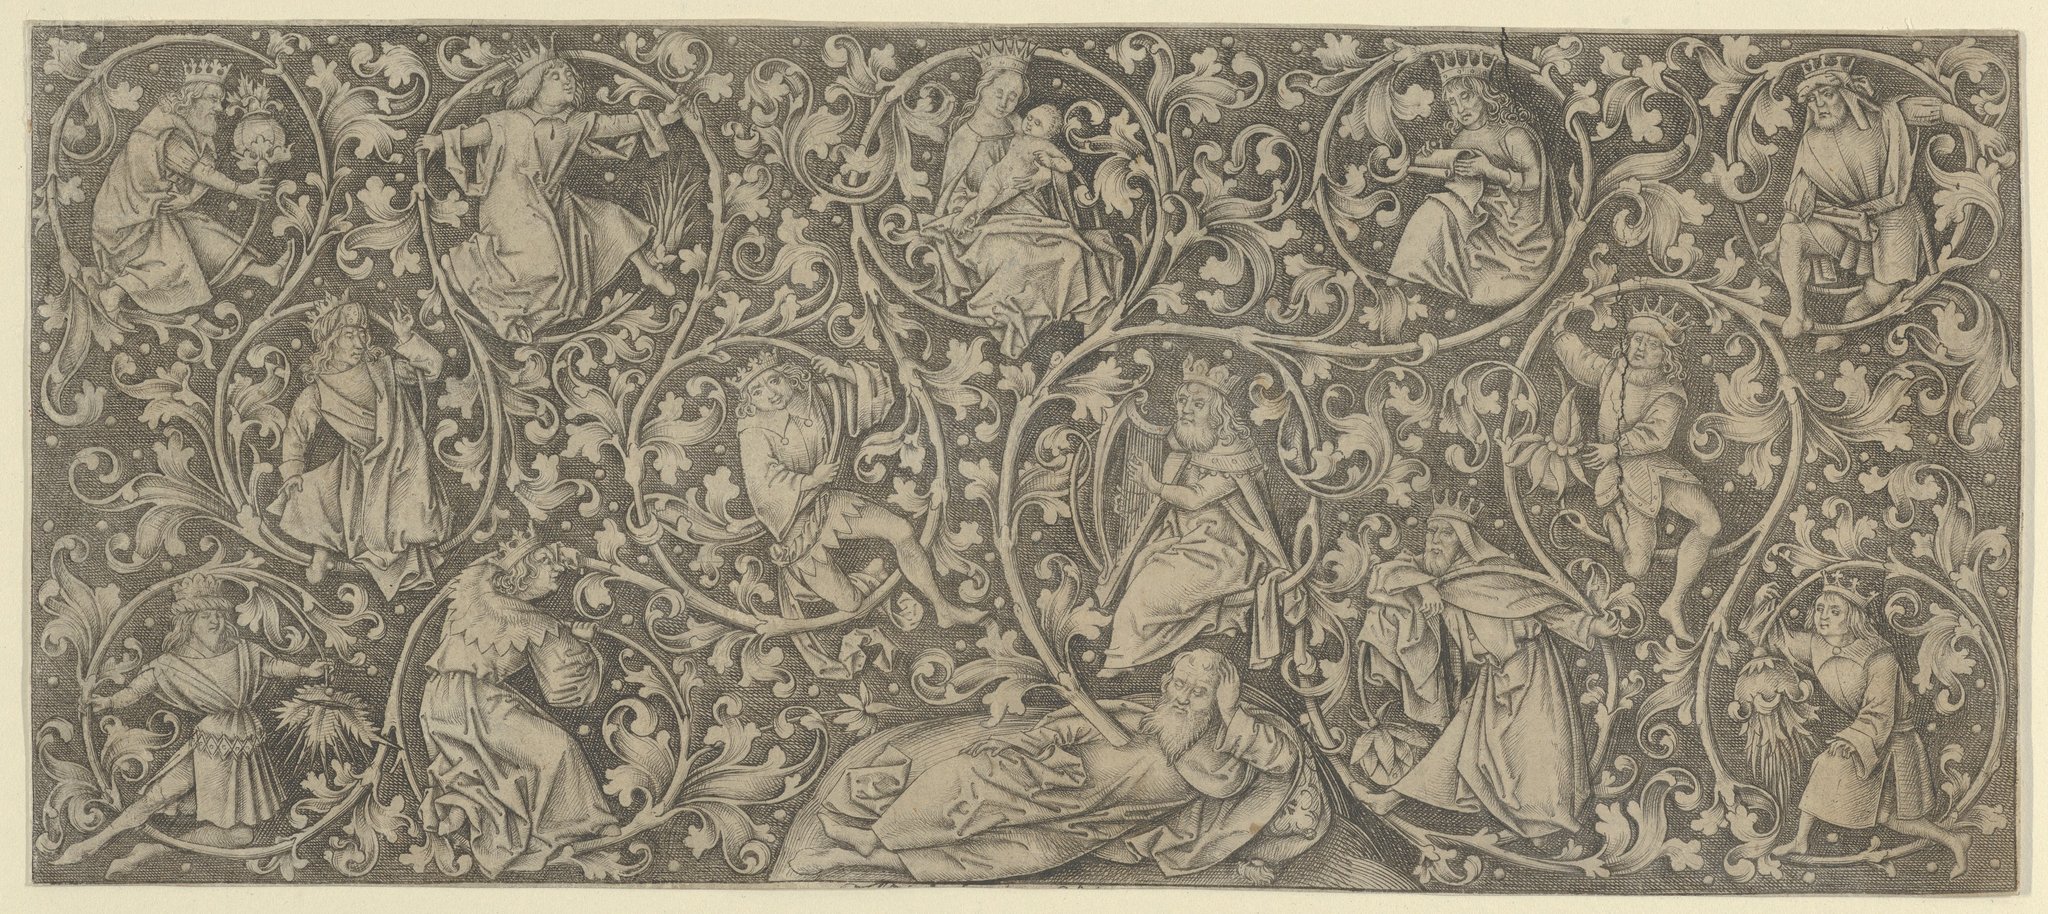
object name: print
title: Ornamental Engraving with the Tree of Jesse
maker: israhel van meckenem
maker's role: artist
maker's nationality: german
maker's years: 1435-1503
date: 1450-1503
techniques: engraving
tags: ornament,men,women